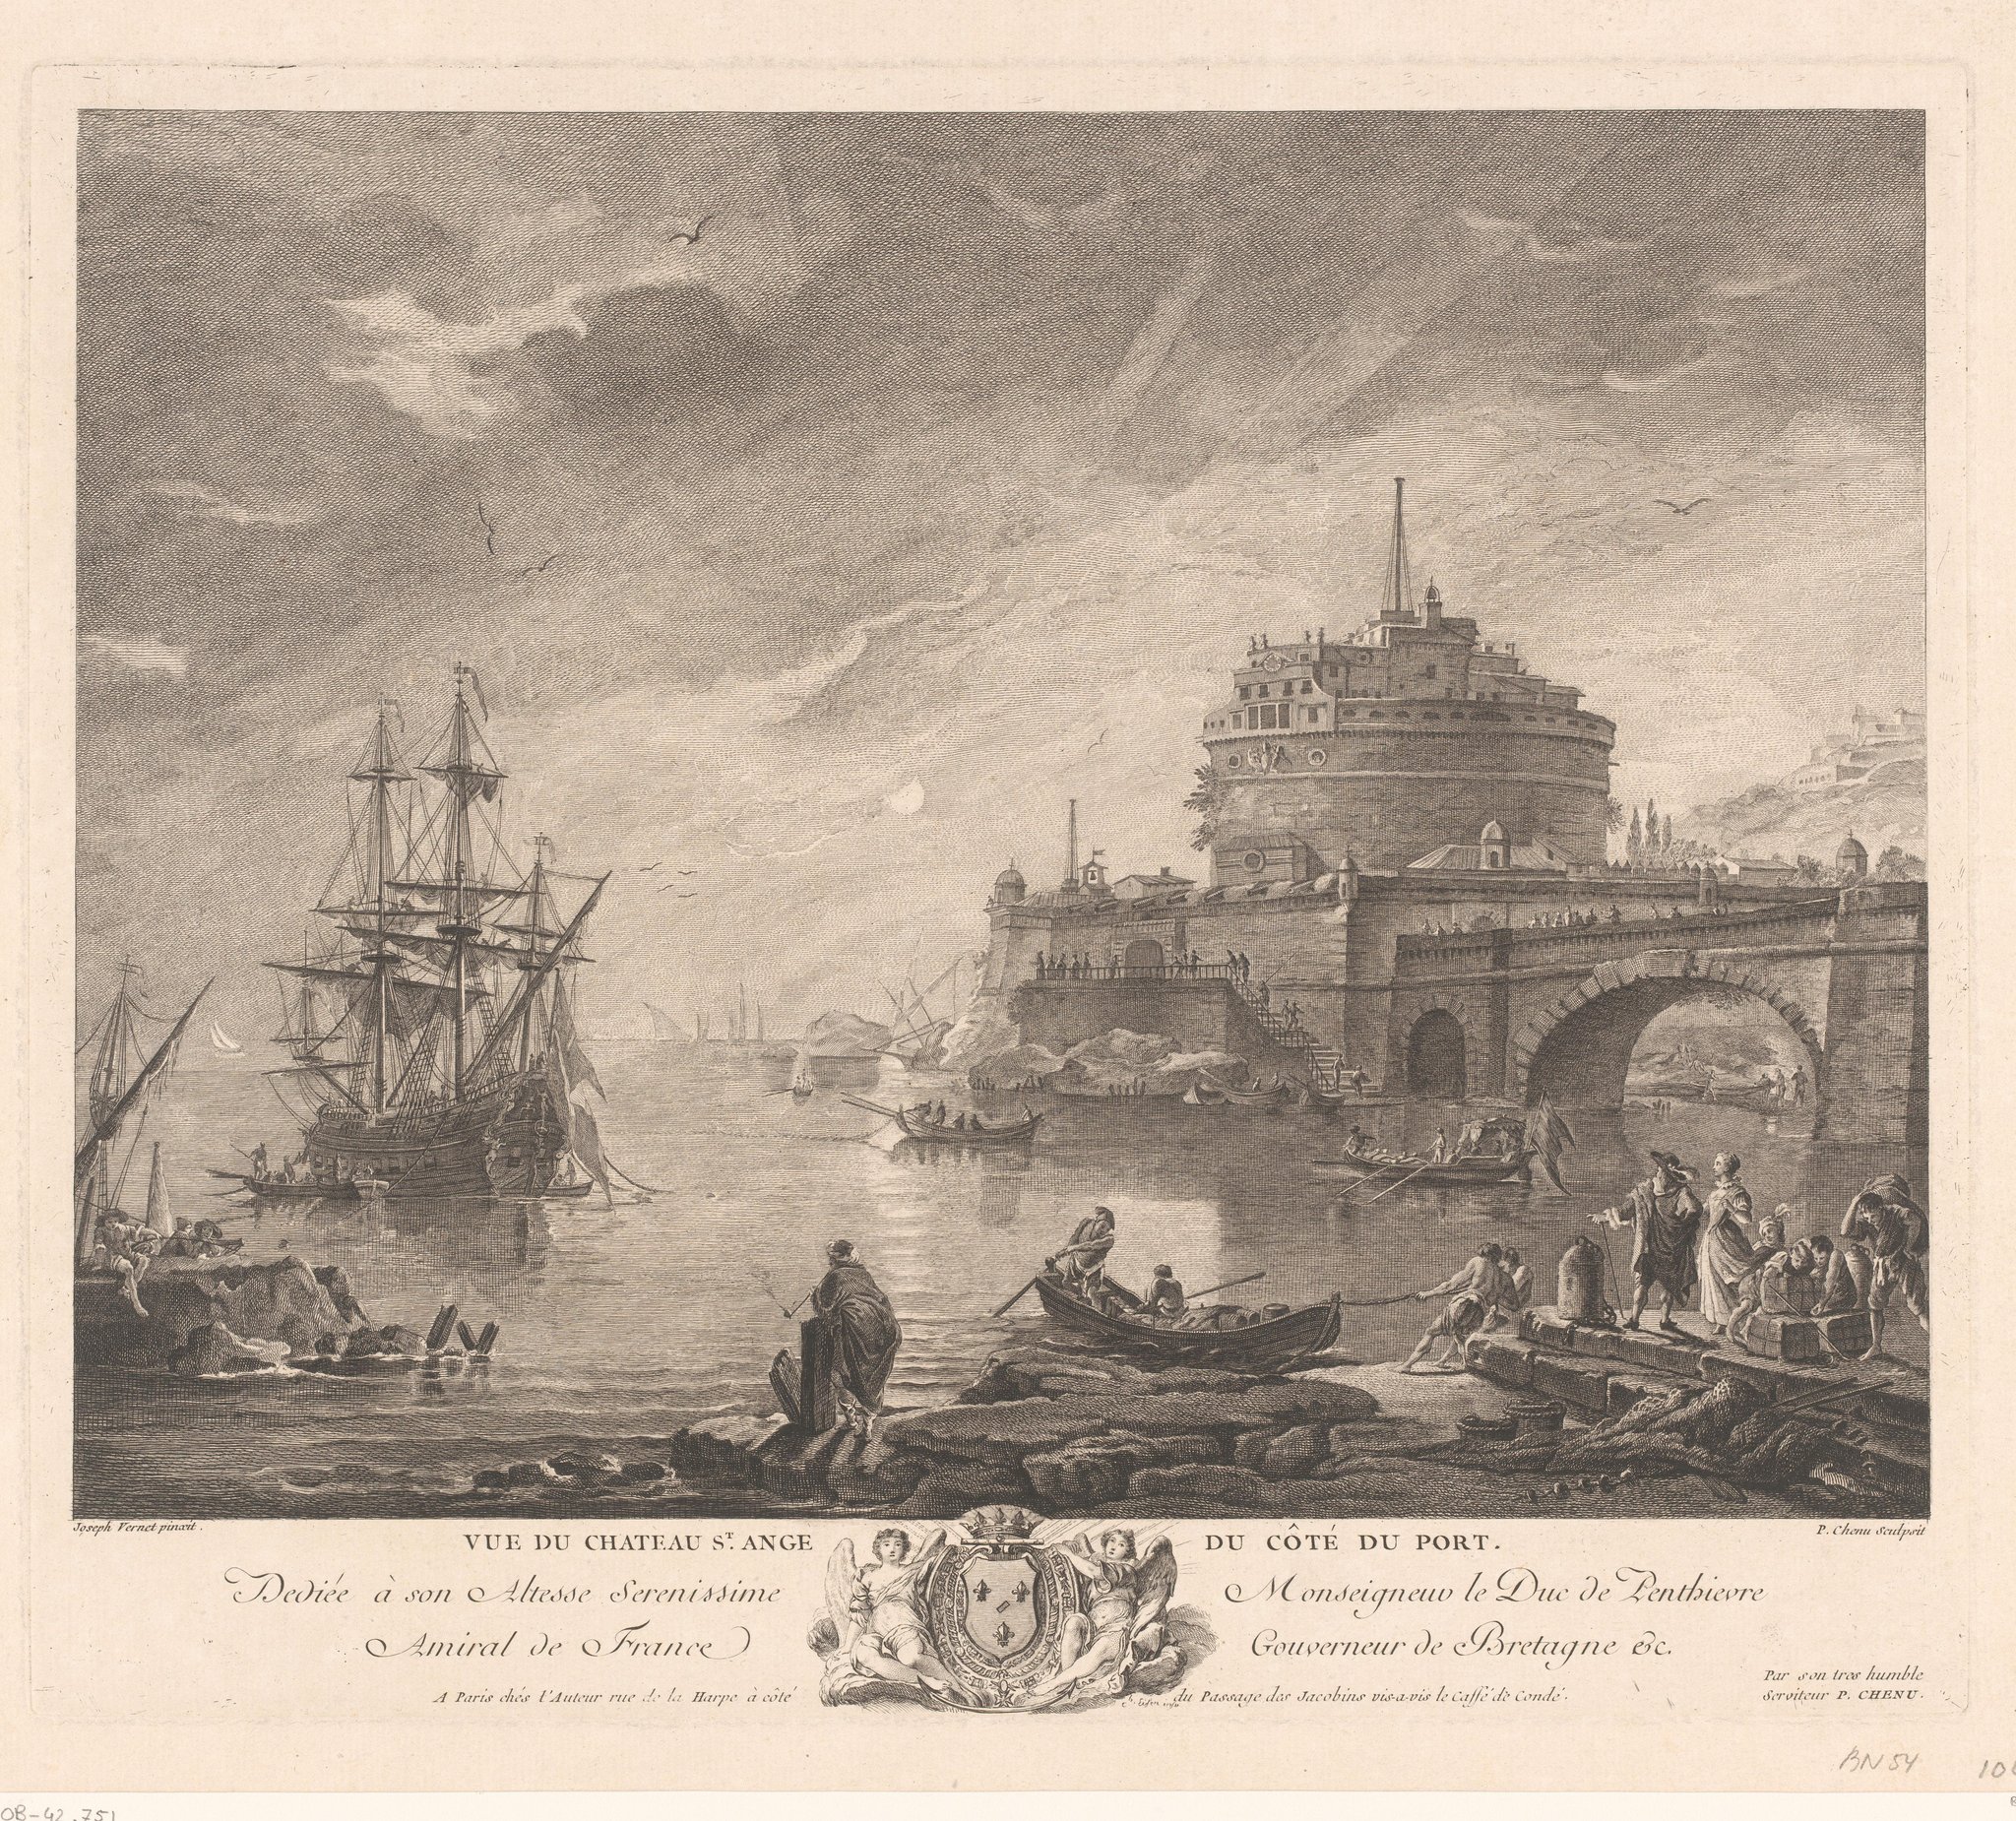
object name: print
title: Gezicht op de Engelenburcht te Rome vanuit de haven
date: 1759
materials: paper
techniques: engraving, etching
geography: france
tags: harbour, city-view in general; 'veduta', ships (in general), armorial bearing, heraldry, boat propelled by man or animal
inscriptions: collector's mark: Lugt 2228